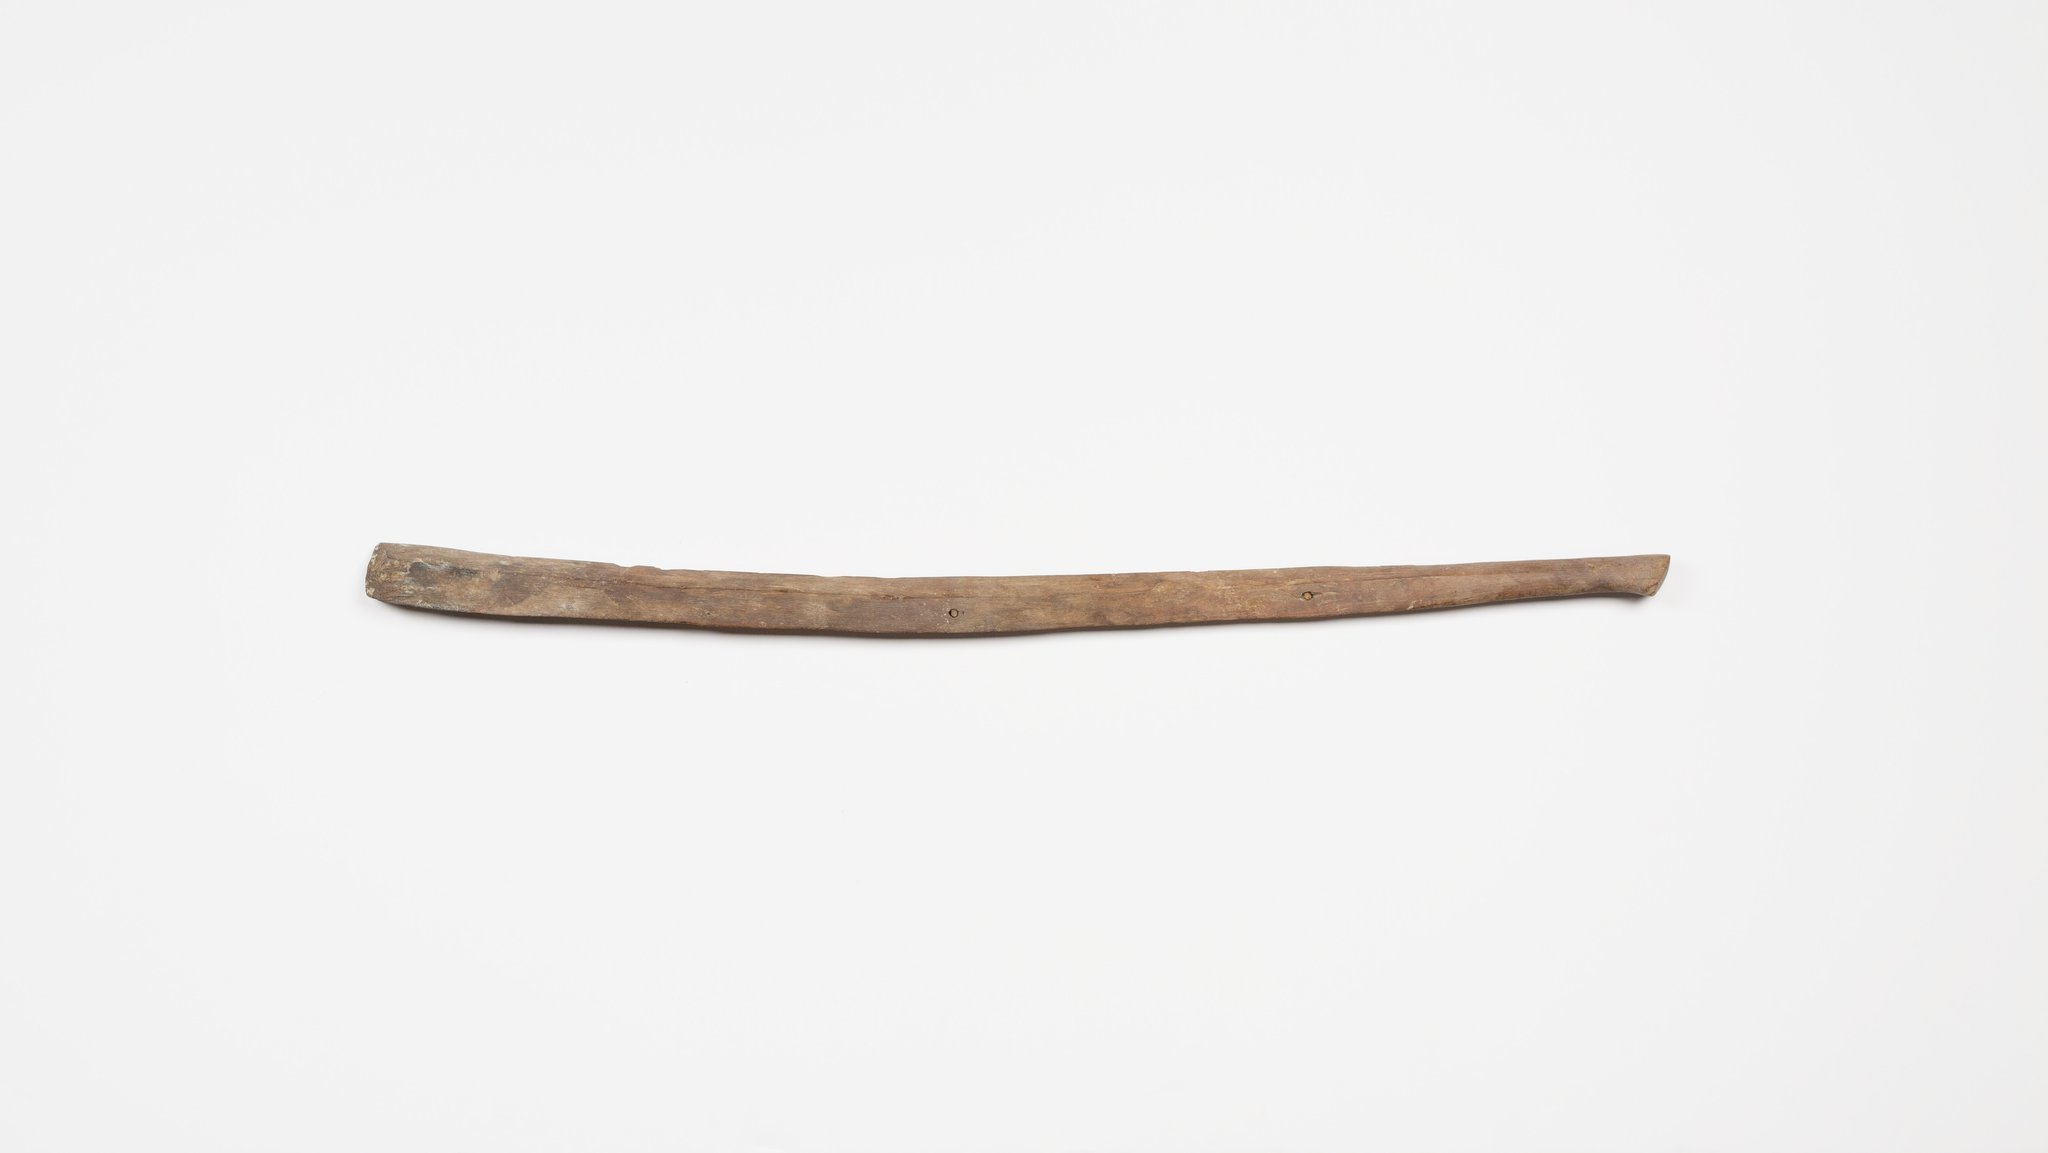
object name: club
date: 2124-1504 BCE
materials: wood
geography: egypt